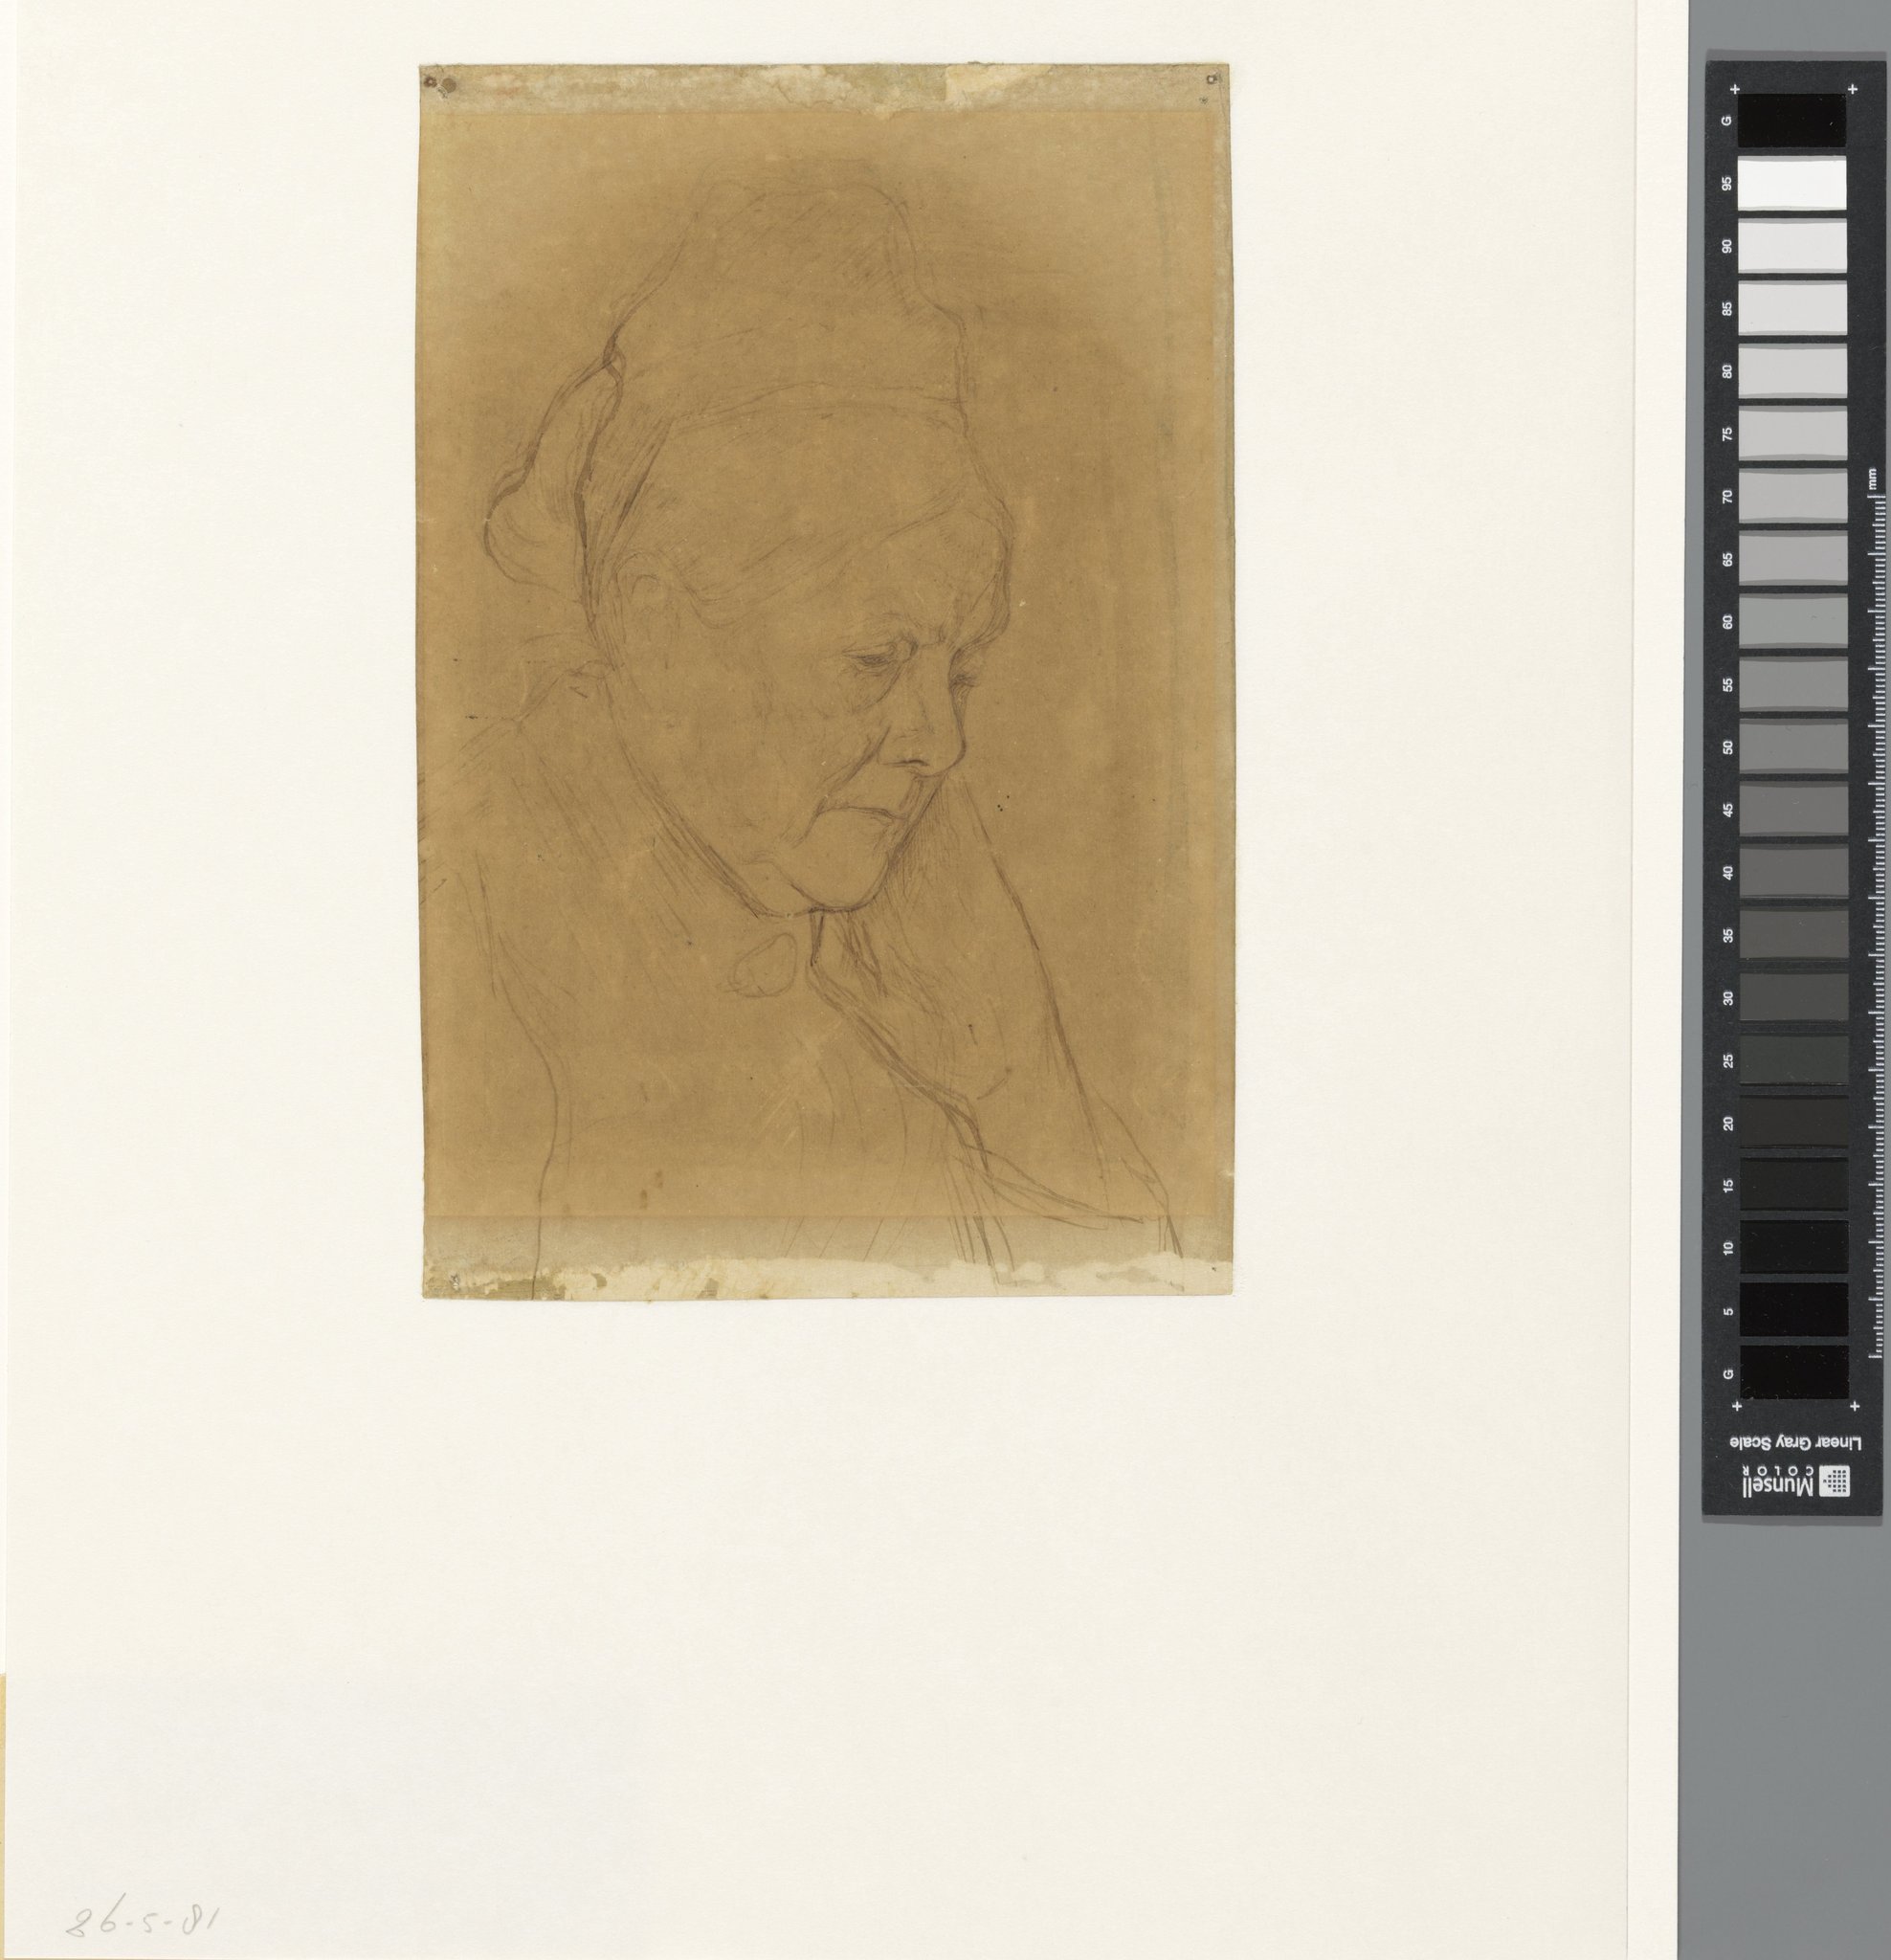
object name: drawing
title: Portret van mevrouw Braet Bisdom van Cattenbroeck-van Hall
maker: jan veth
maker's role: designer, draughtsman, painter, print maker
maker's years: 1864-1925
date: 1874-1925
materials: ink, paper, pencil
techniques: pen